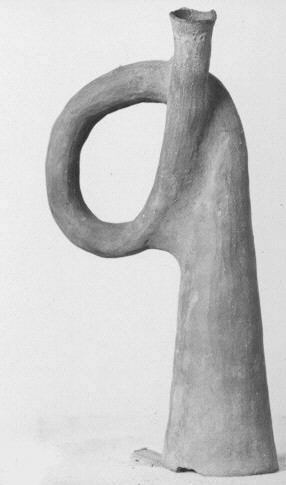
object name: trumpet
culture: mochica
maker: mochica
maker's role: maker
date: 1000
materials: clay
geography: peru